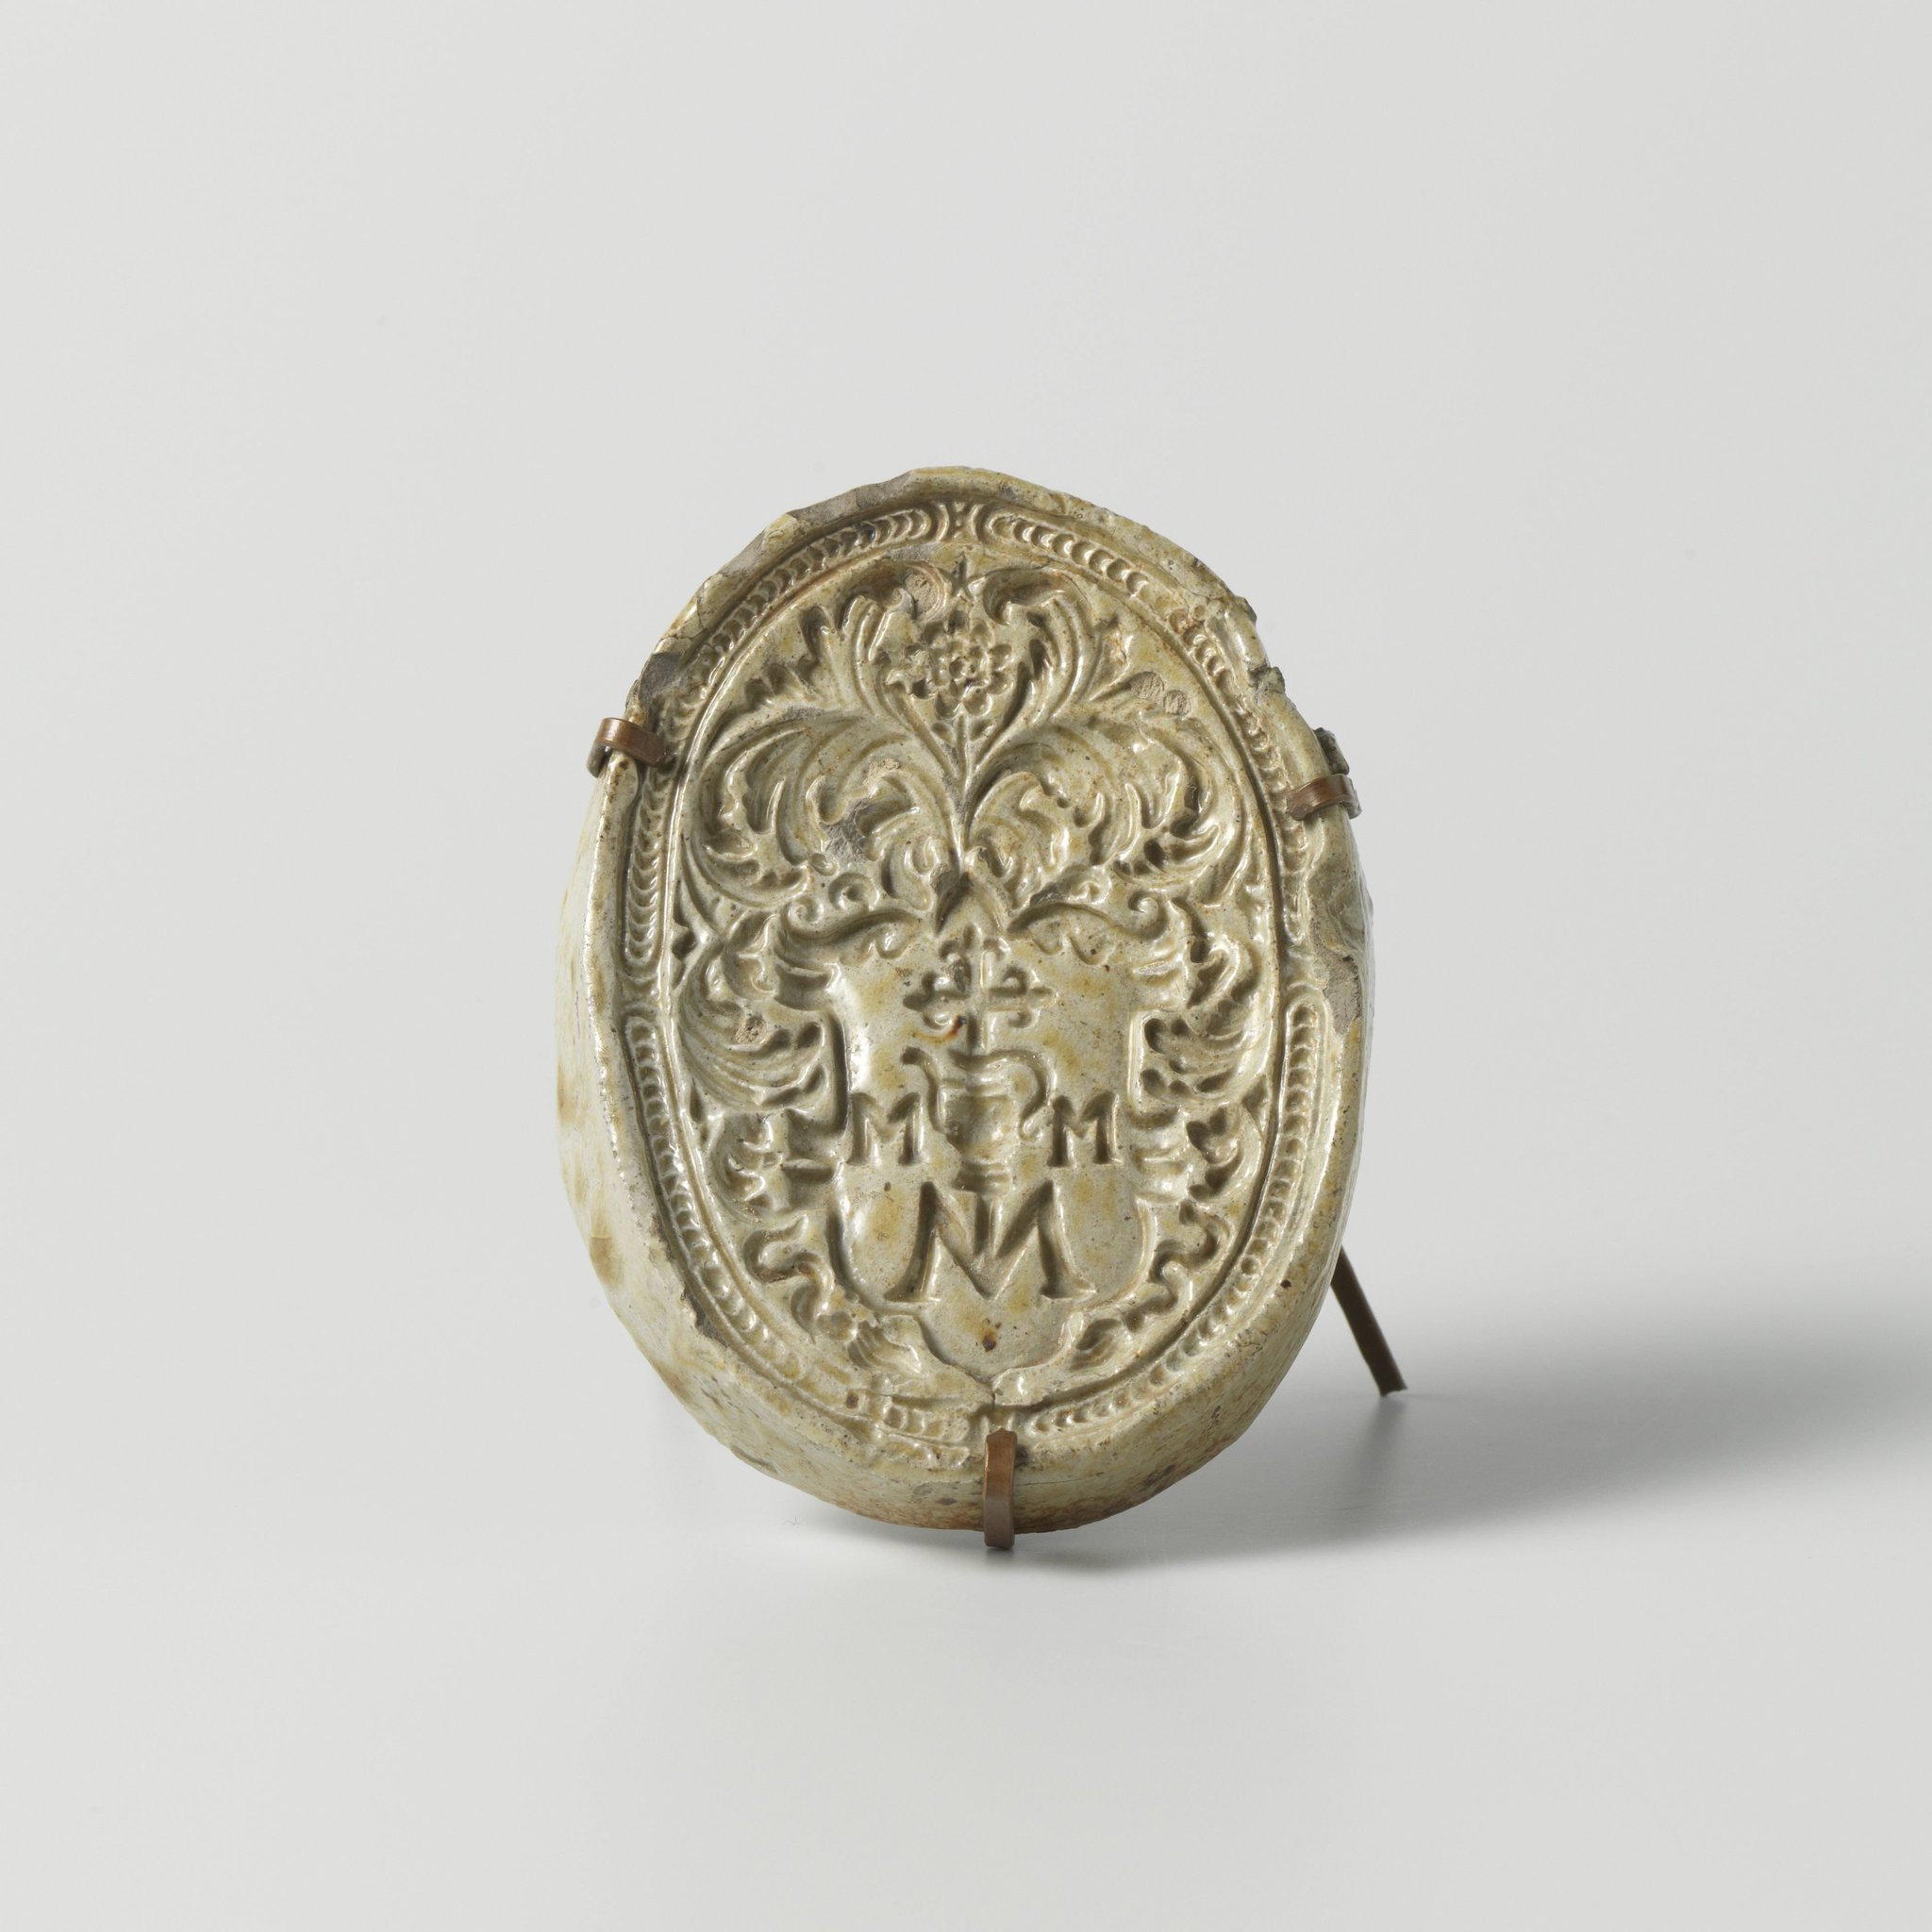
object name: stamp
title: Mould for relief decoration of stoneware, with an escutcheon and a housemark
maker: Anonymous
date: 1580-1600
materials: glaze, stoneware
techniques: printing, firing, forming, vitrification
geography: raeren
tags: armorial bearing, heraldry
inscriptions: inscription: ‘M’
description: Stempel van steengoed, voor het drukken van decoraties. Op de stempel een wapen met driemaal de letter 'M', omringd door bladranken. De tempel is gevat in een ijzeren standaard. Raeren.